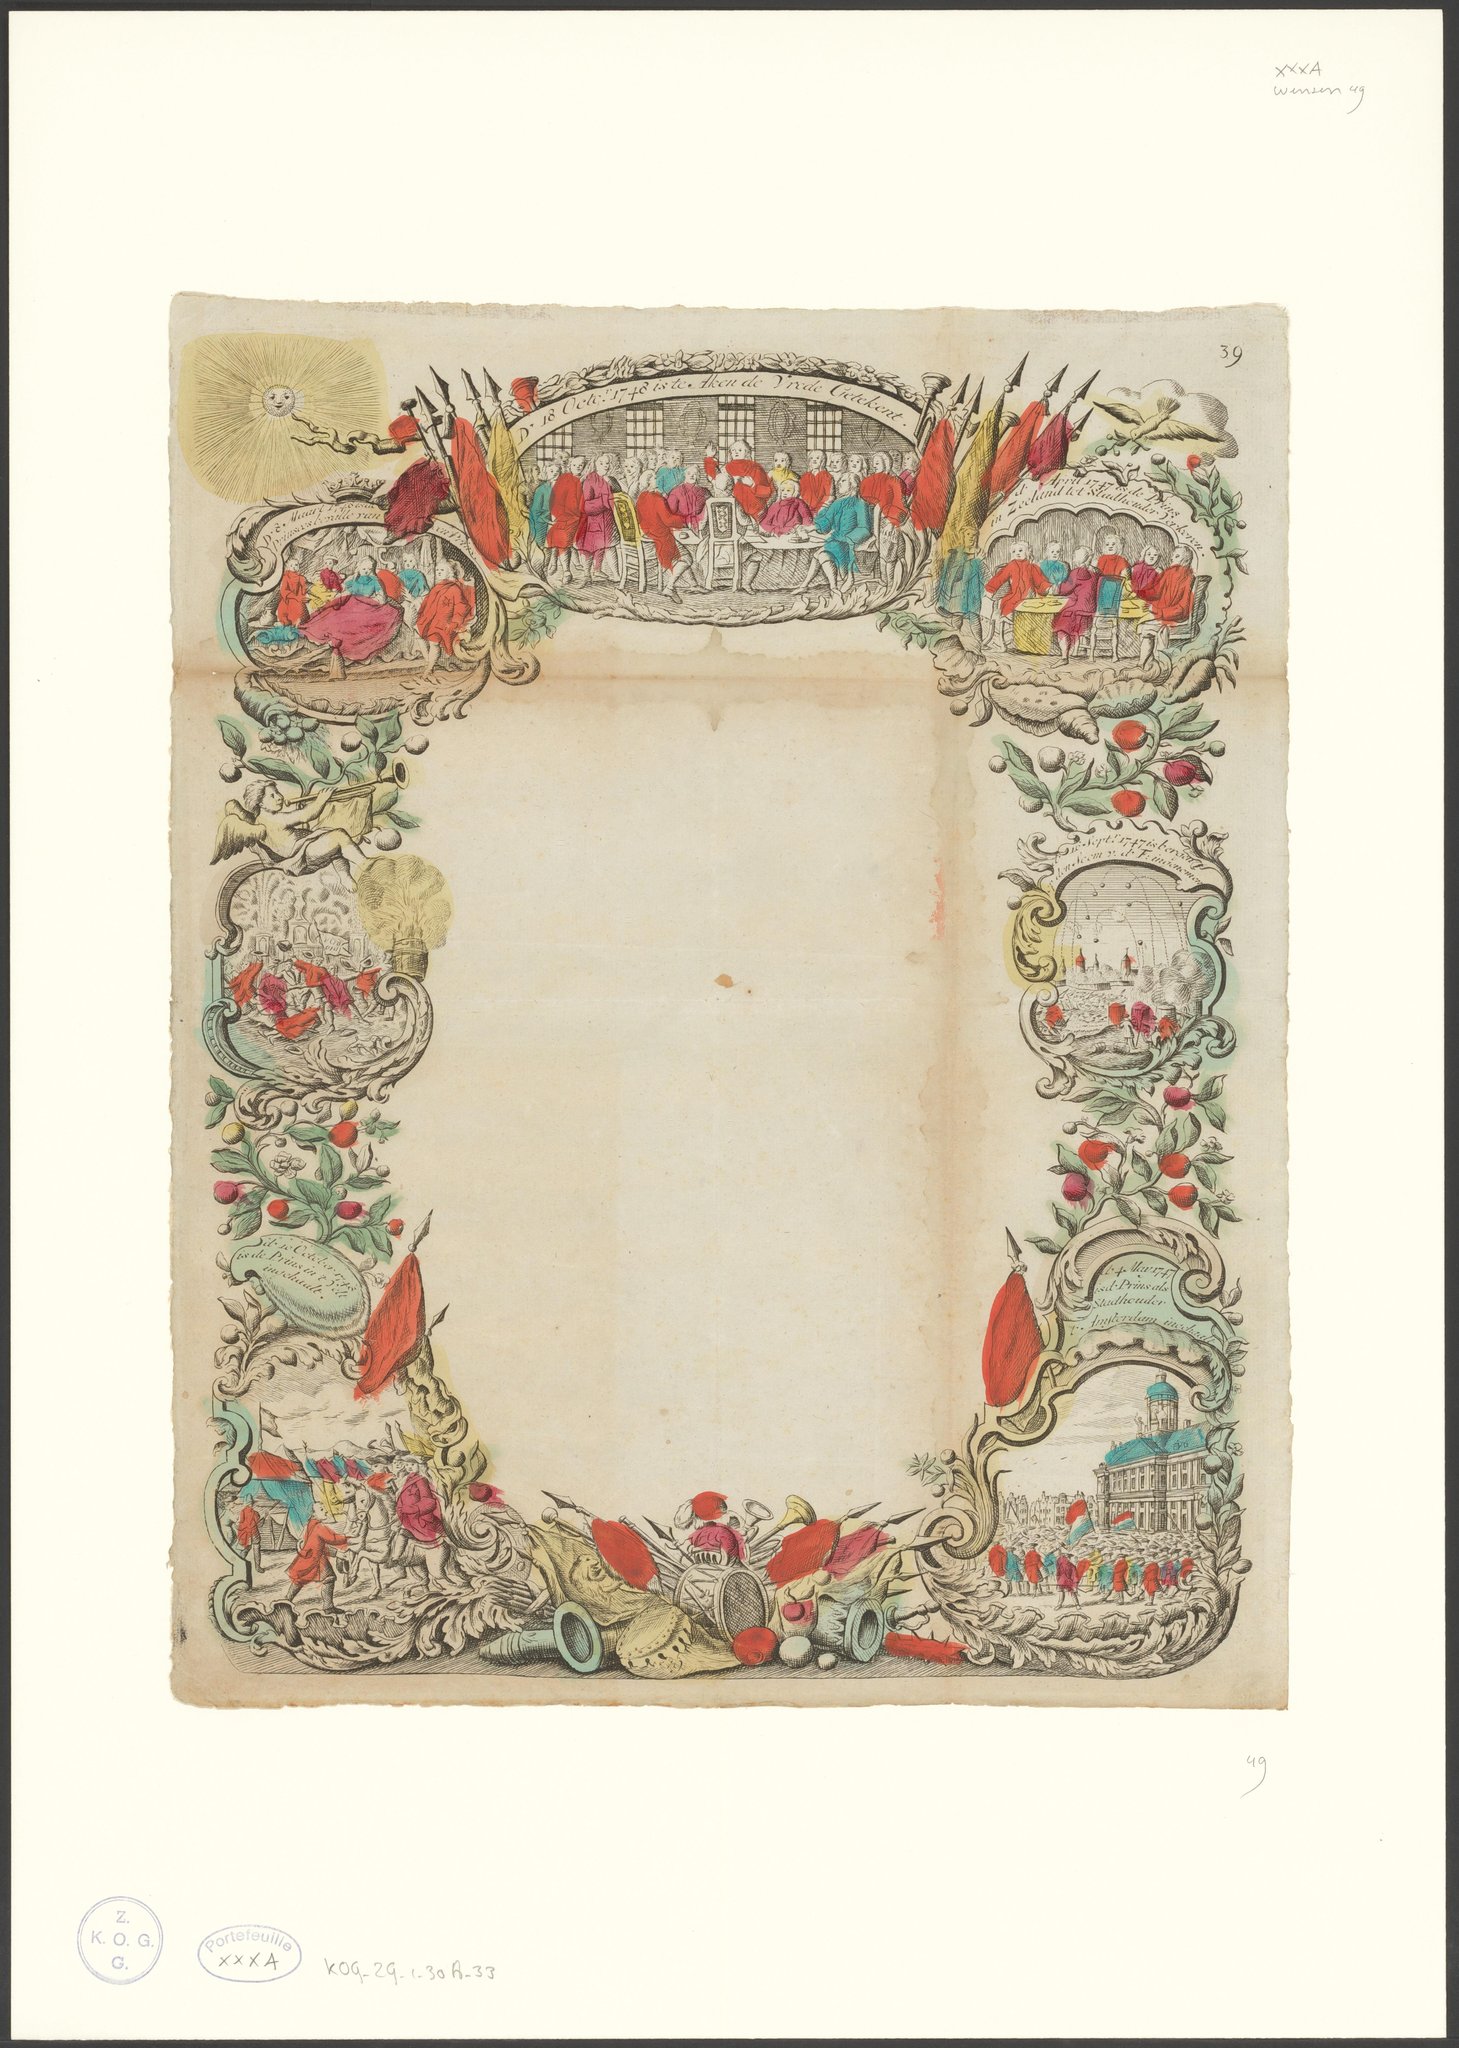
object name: print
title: Blanco wensbrief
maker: Anonymous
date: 1748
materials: paper, watercolor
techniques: engraving, hand coloring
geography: netherlands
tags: battle, fighting in general, january 1 (~ festivities), signing of peace treaty, concluding the peace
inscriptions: collector's mark: Lugt 1641, collector's mark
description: Nieuwjaarswens zonder tekst. Voorgedrukt blad met een kader gevormd door historische voorstellingen uit de jaren 1747 en 1748. Linksboven een stralende zon. Genummerd rechtsboven: 39. Onderwerpsrubrieken binnen de Atlas Zeden en Gewoonten: Nieuwjaars- en kermiswenschen.